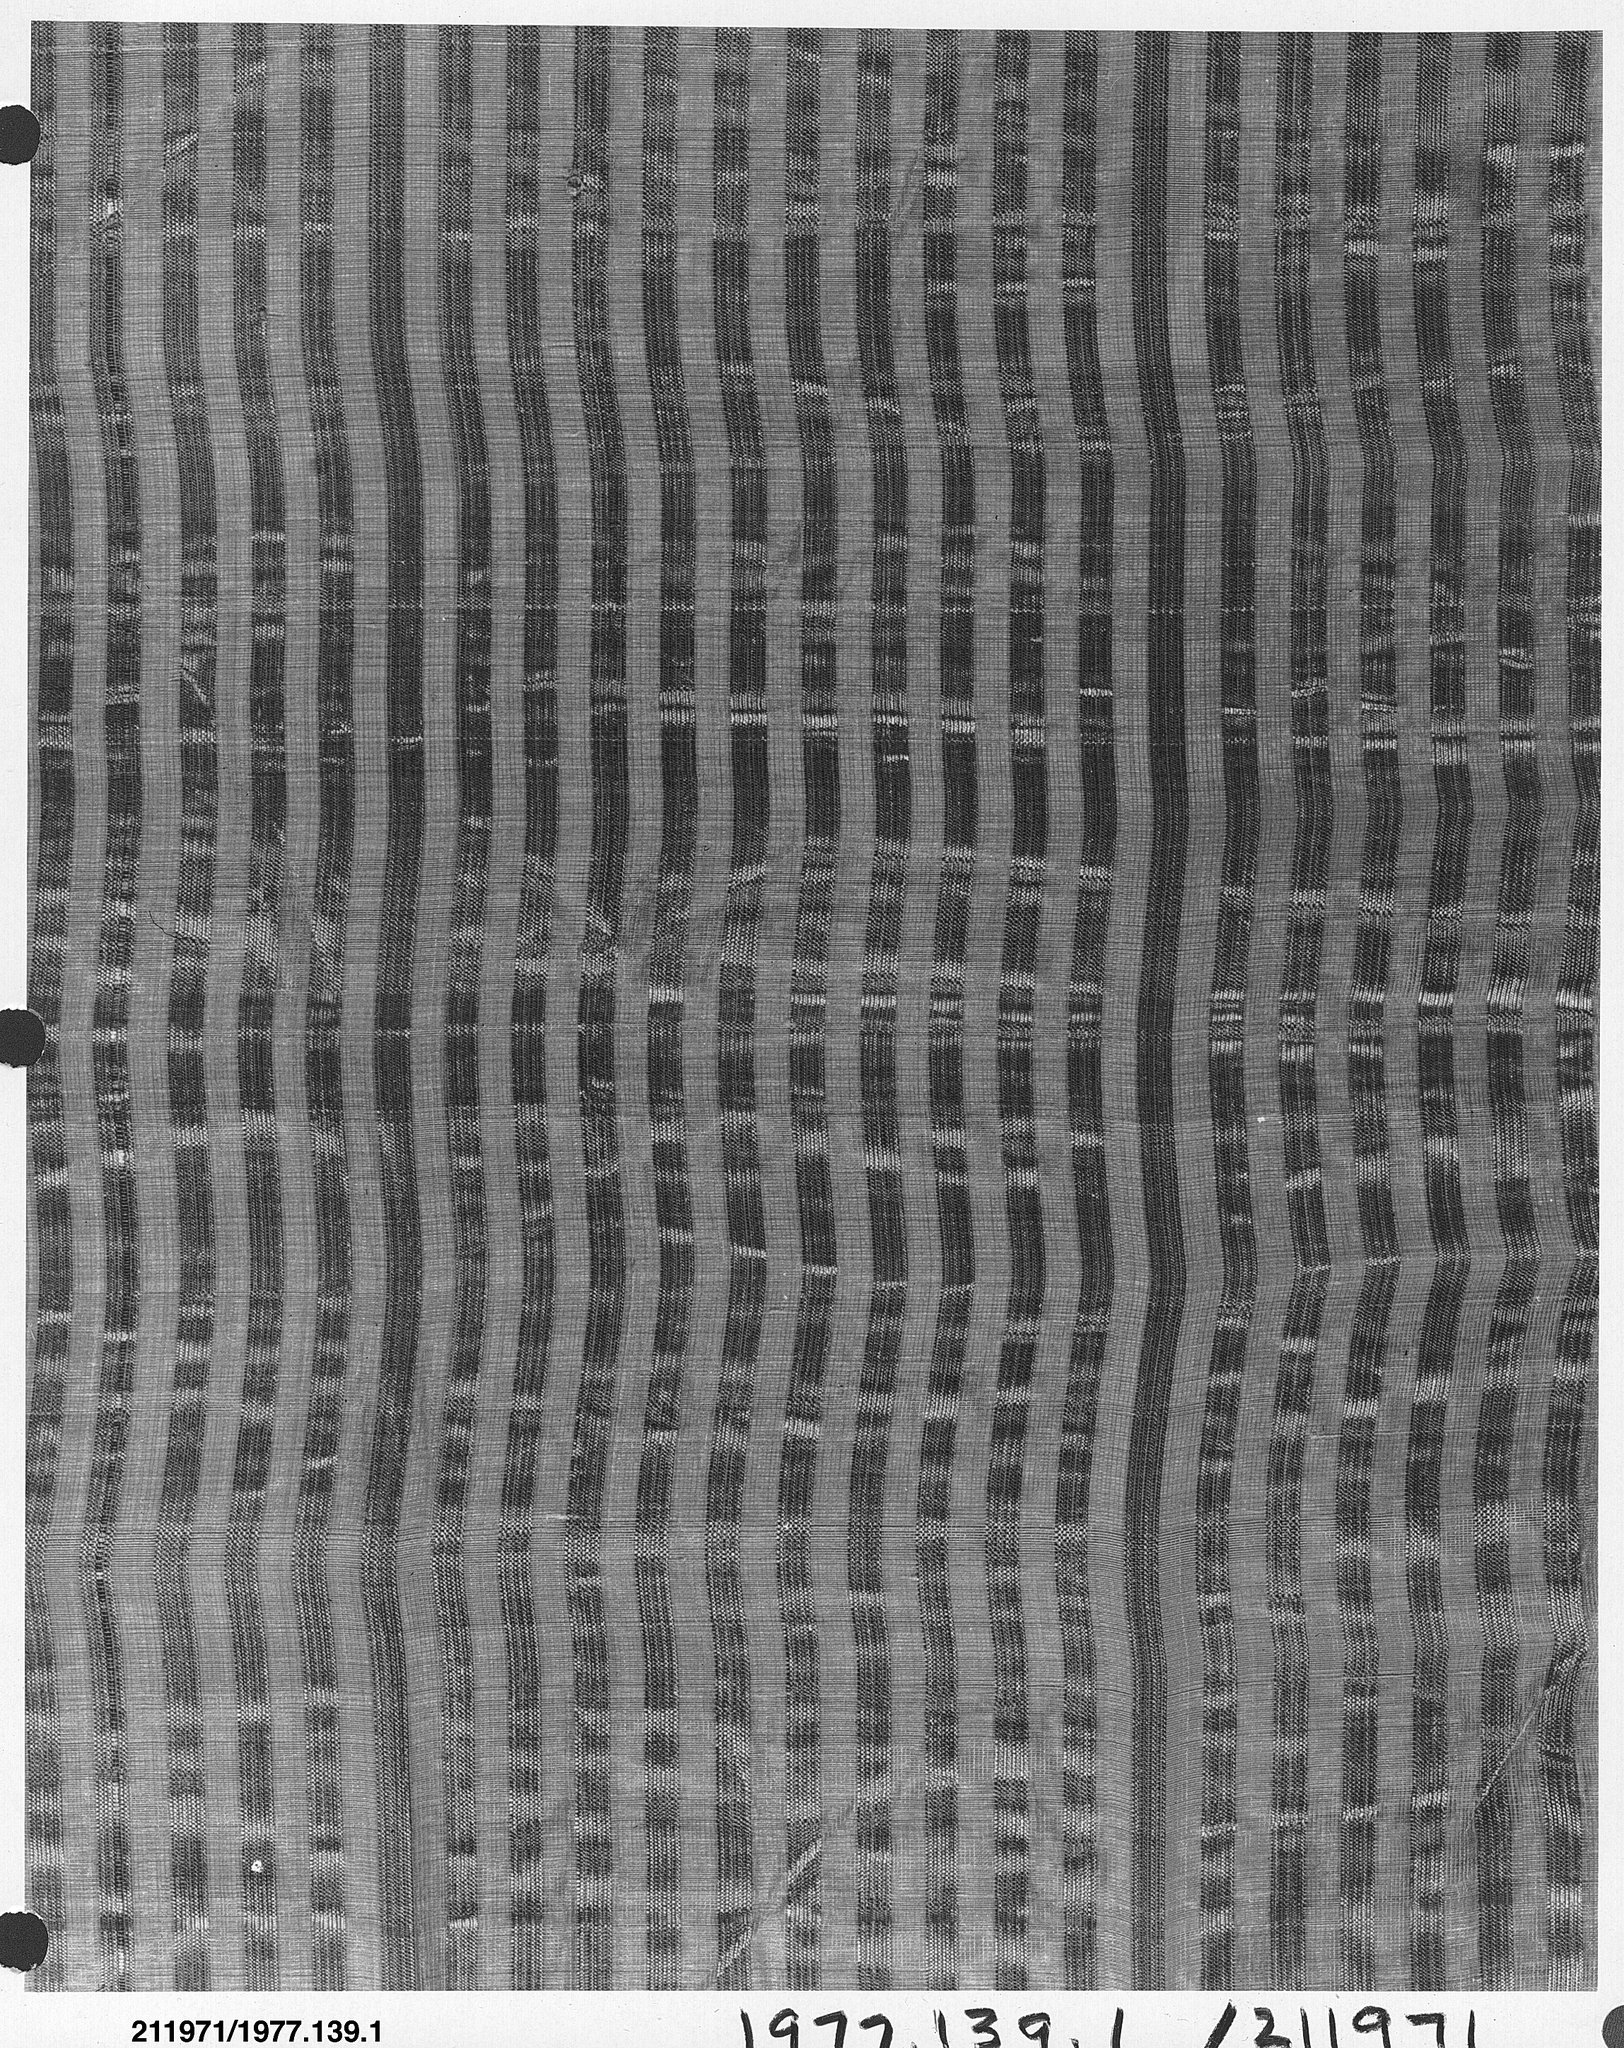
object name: piece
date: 1850